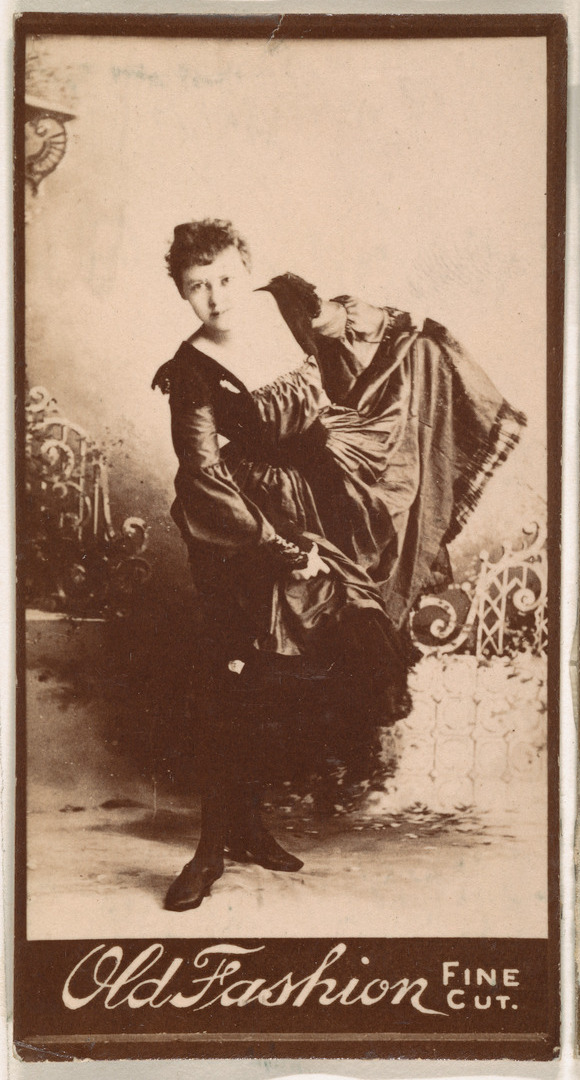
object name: photograph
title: Dancing, from the Actresses series (N664) promoting Old Fashion Fine Cut Tobacco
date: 1888-1890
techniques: albumen silver print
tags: portraits,women,dancers